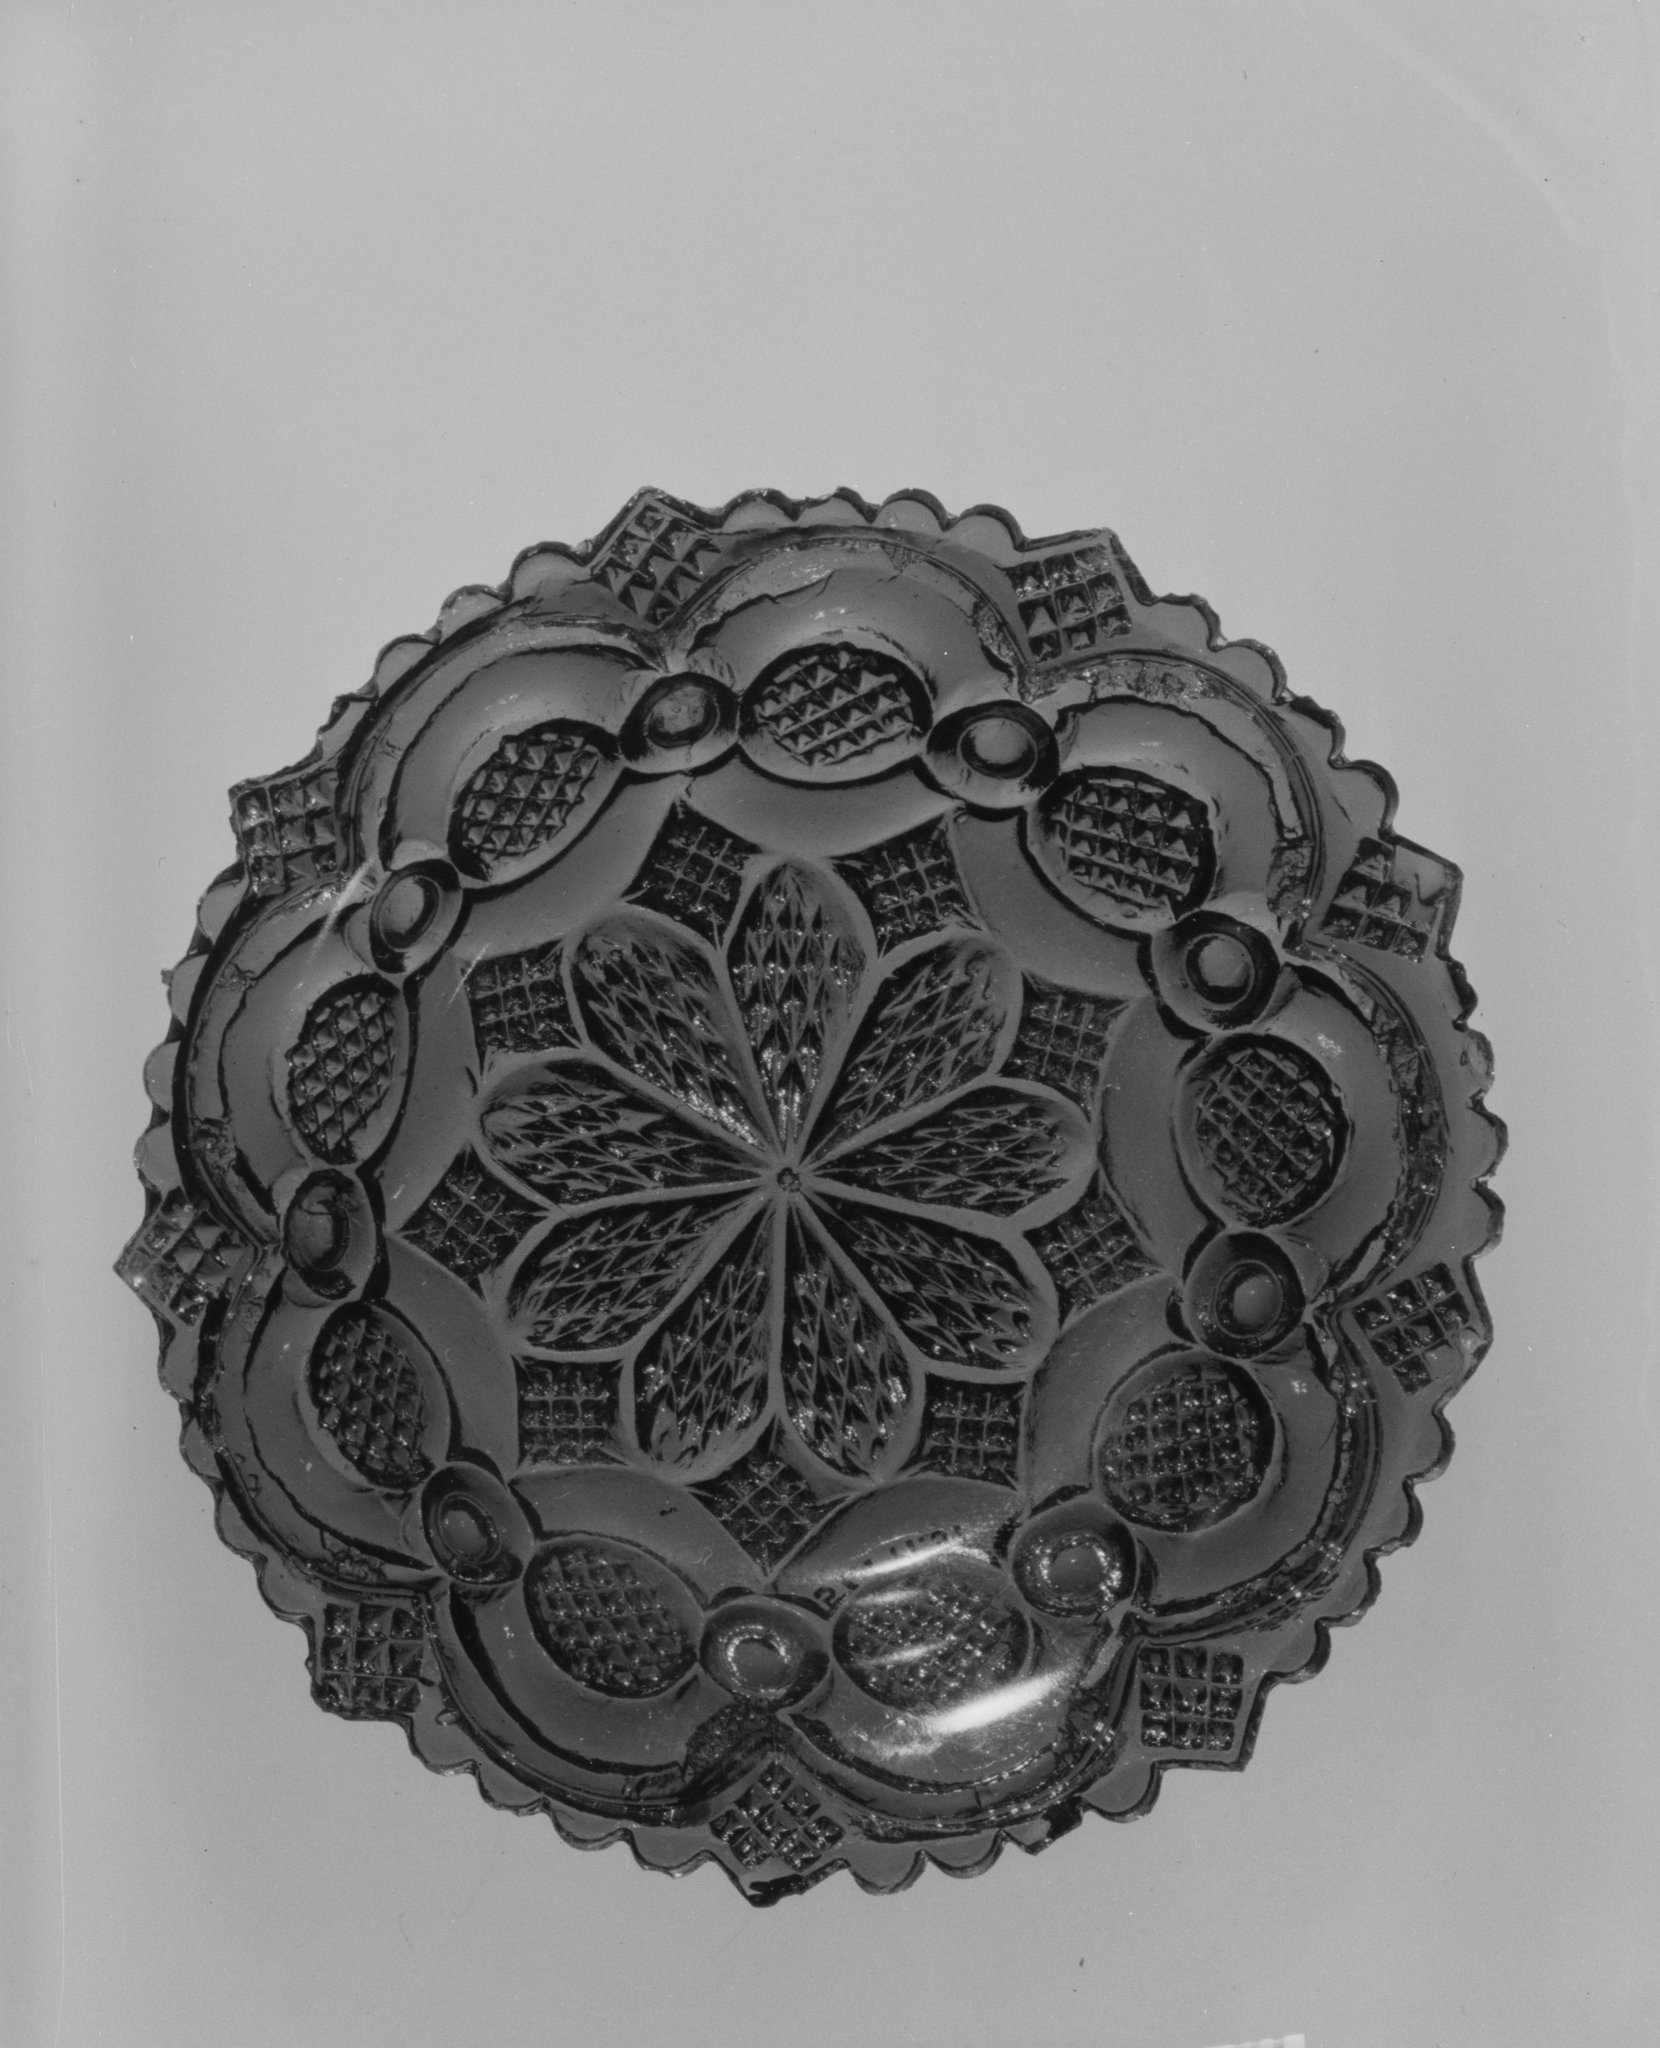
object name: dish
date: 1835-1850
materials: glass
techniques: pressed